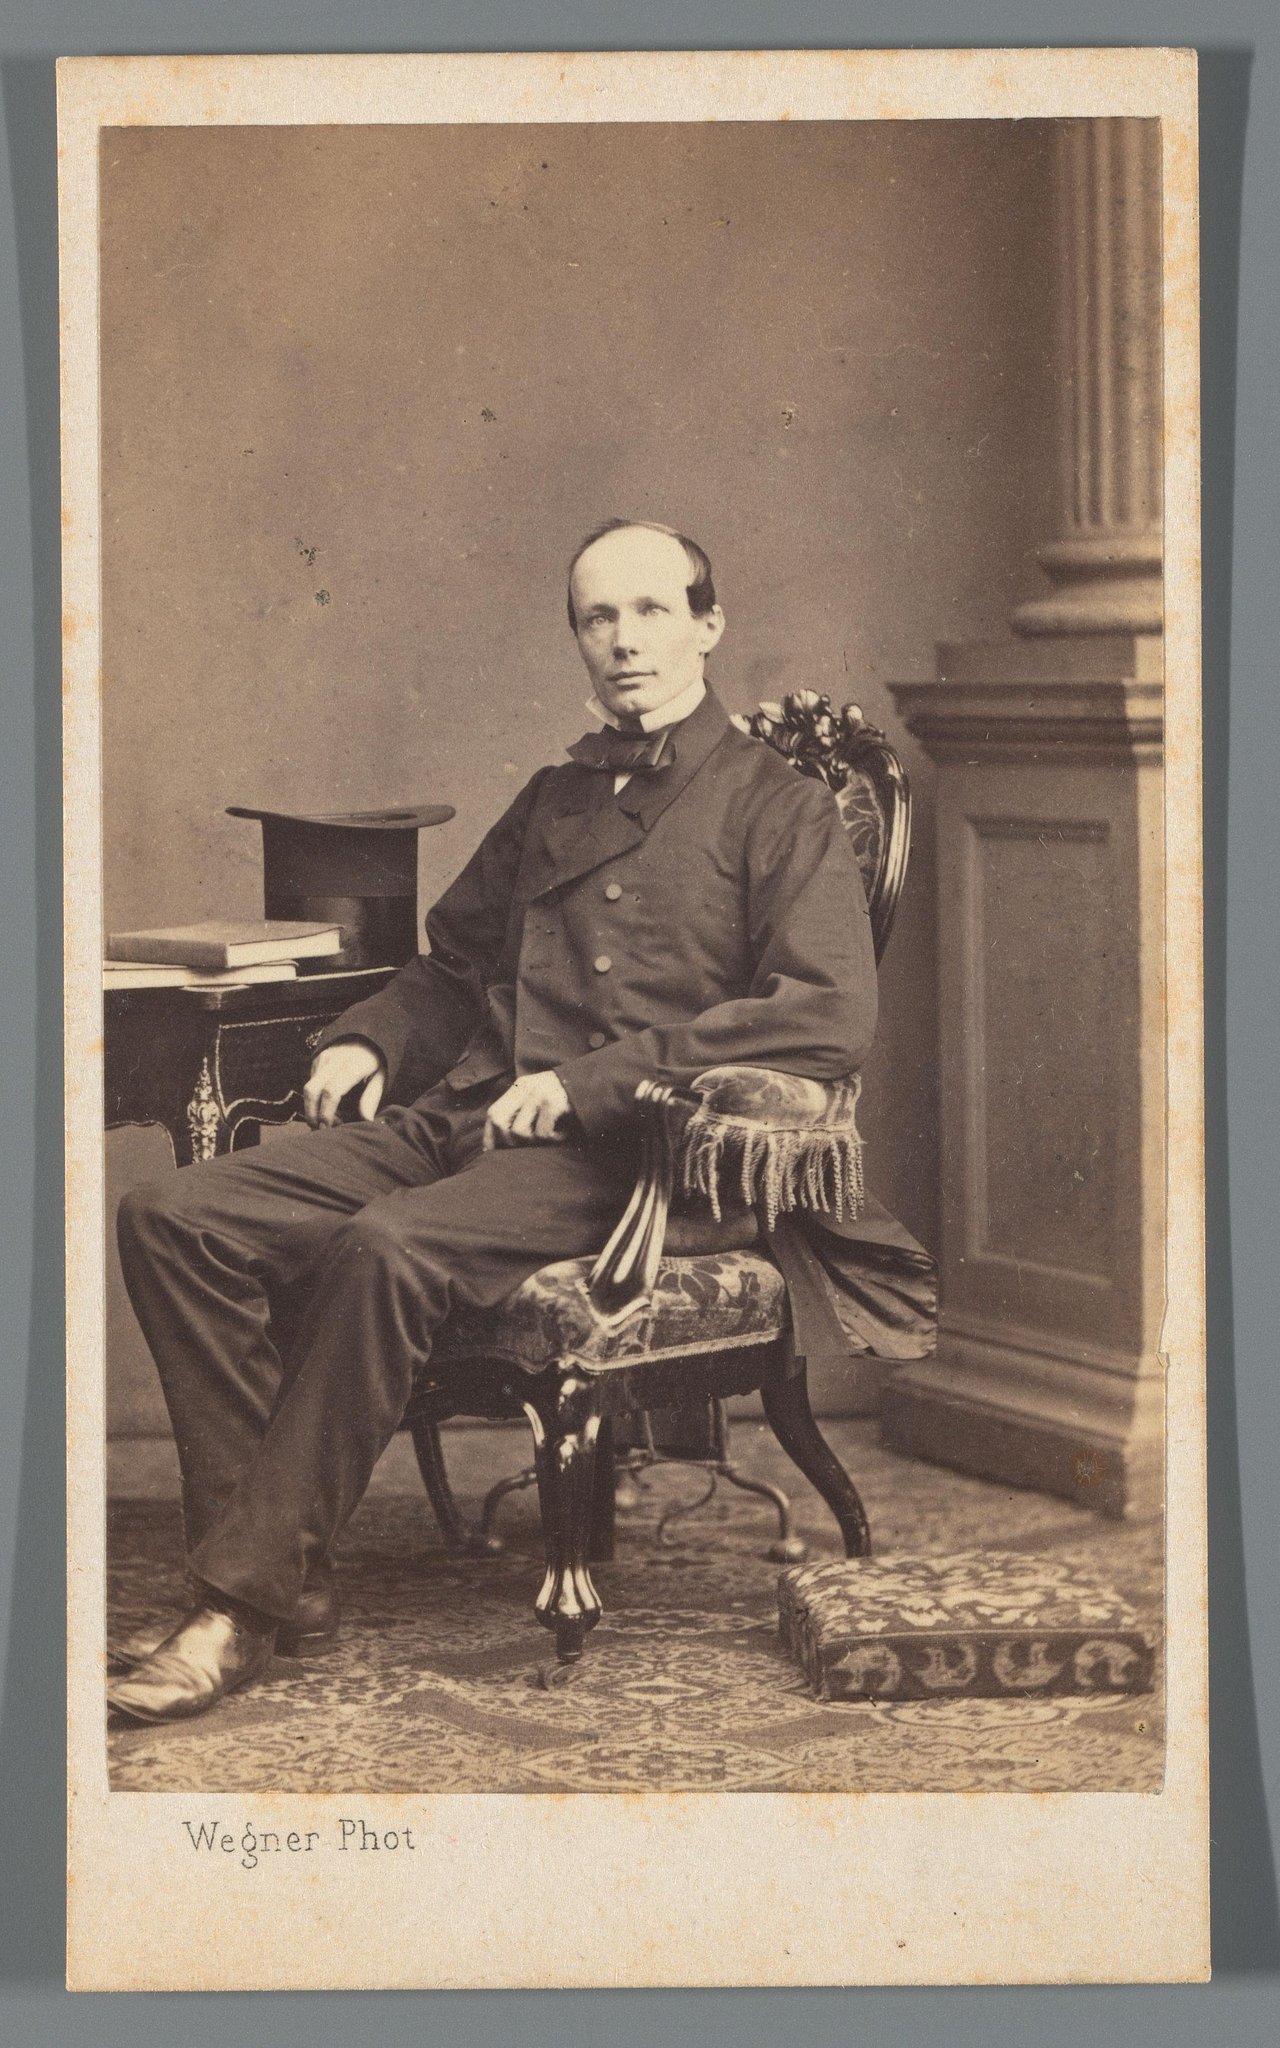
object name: photograph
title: Studioportret van onbekende man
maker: louis wegner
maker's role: print maker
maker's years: 1816-1864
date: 1855-1864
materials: cardboard, photographic support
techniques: albumen print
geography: amsterdam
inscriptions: name: ‘PHOTOGR ATELIER / L. WEGNER / Prinsengracht BB 439 / AMSTERDAM’, name: ‘Wegner Phot’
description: Zittende man. Op de tafel achter hem een hoge hoed en een paar boeken.